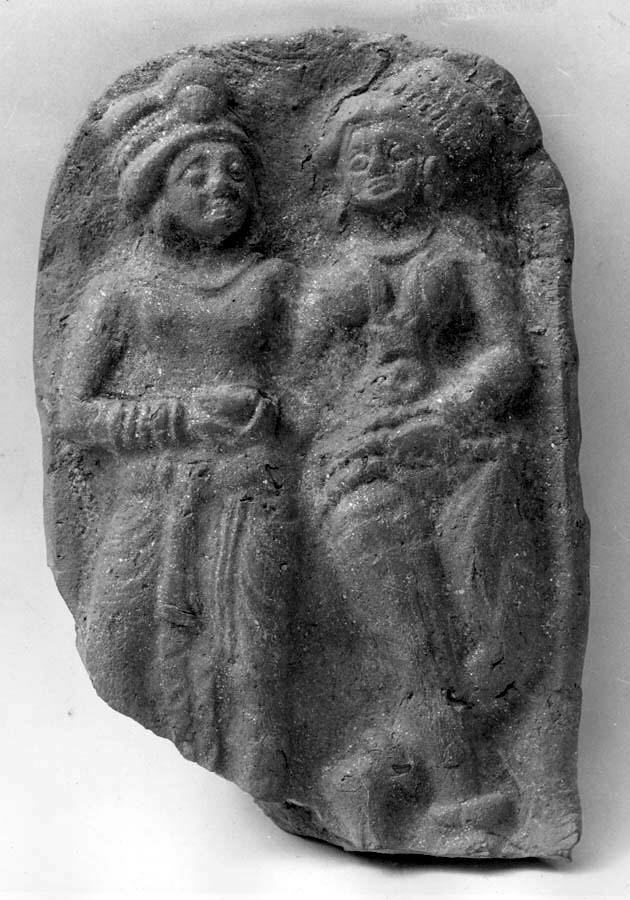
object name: relief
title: Princely Couple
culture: indian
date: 101-133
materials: terracotta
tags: shunga,couples